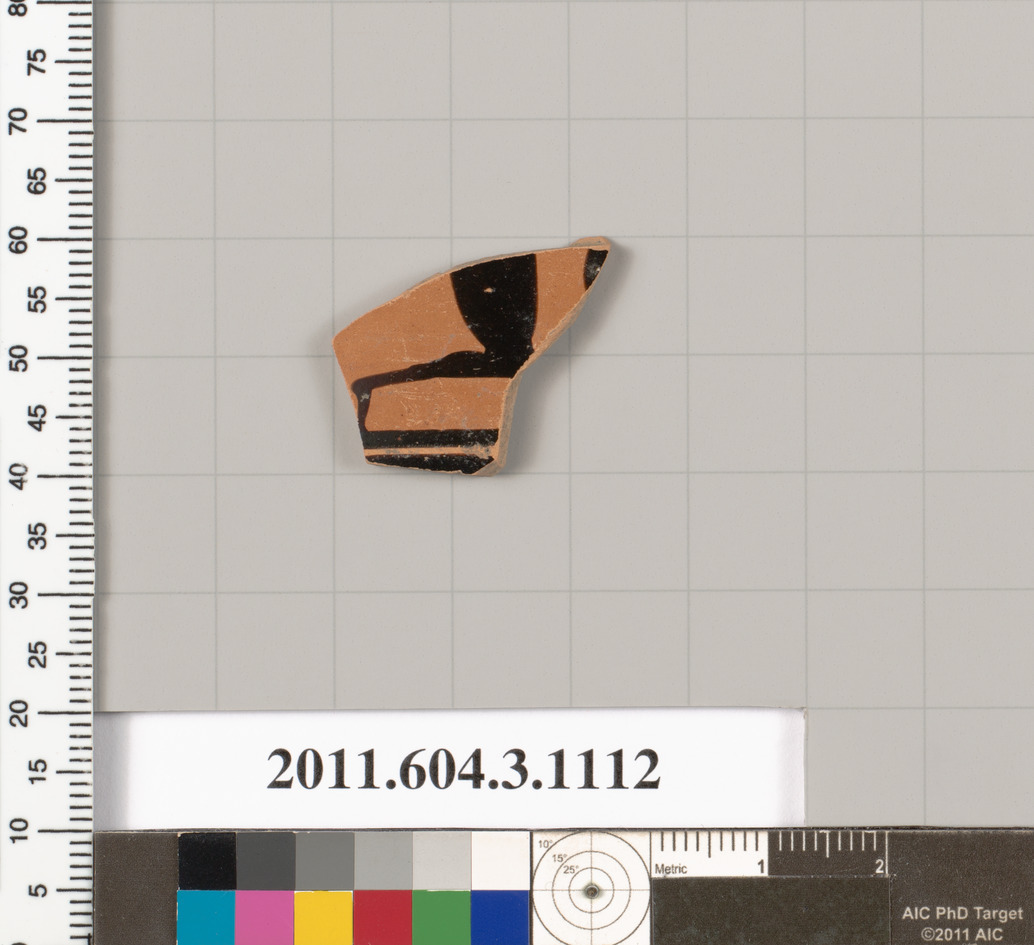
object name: mastoid or kyathos fragment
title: Terracotta fragment of a mastoid (drinking cup with narrow base) or a kyathos (cup-shaped ladle)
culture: greek, attic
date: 534-468 BCE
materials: terracotta